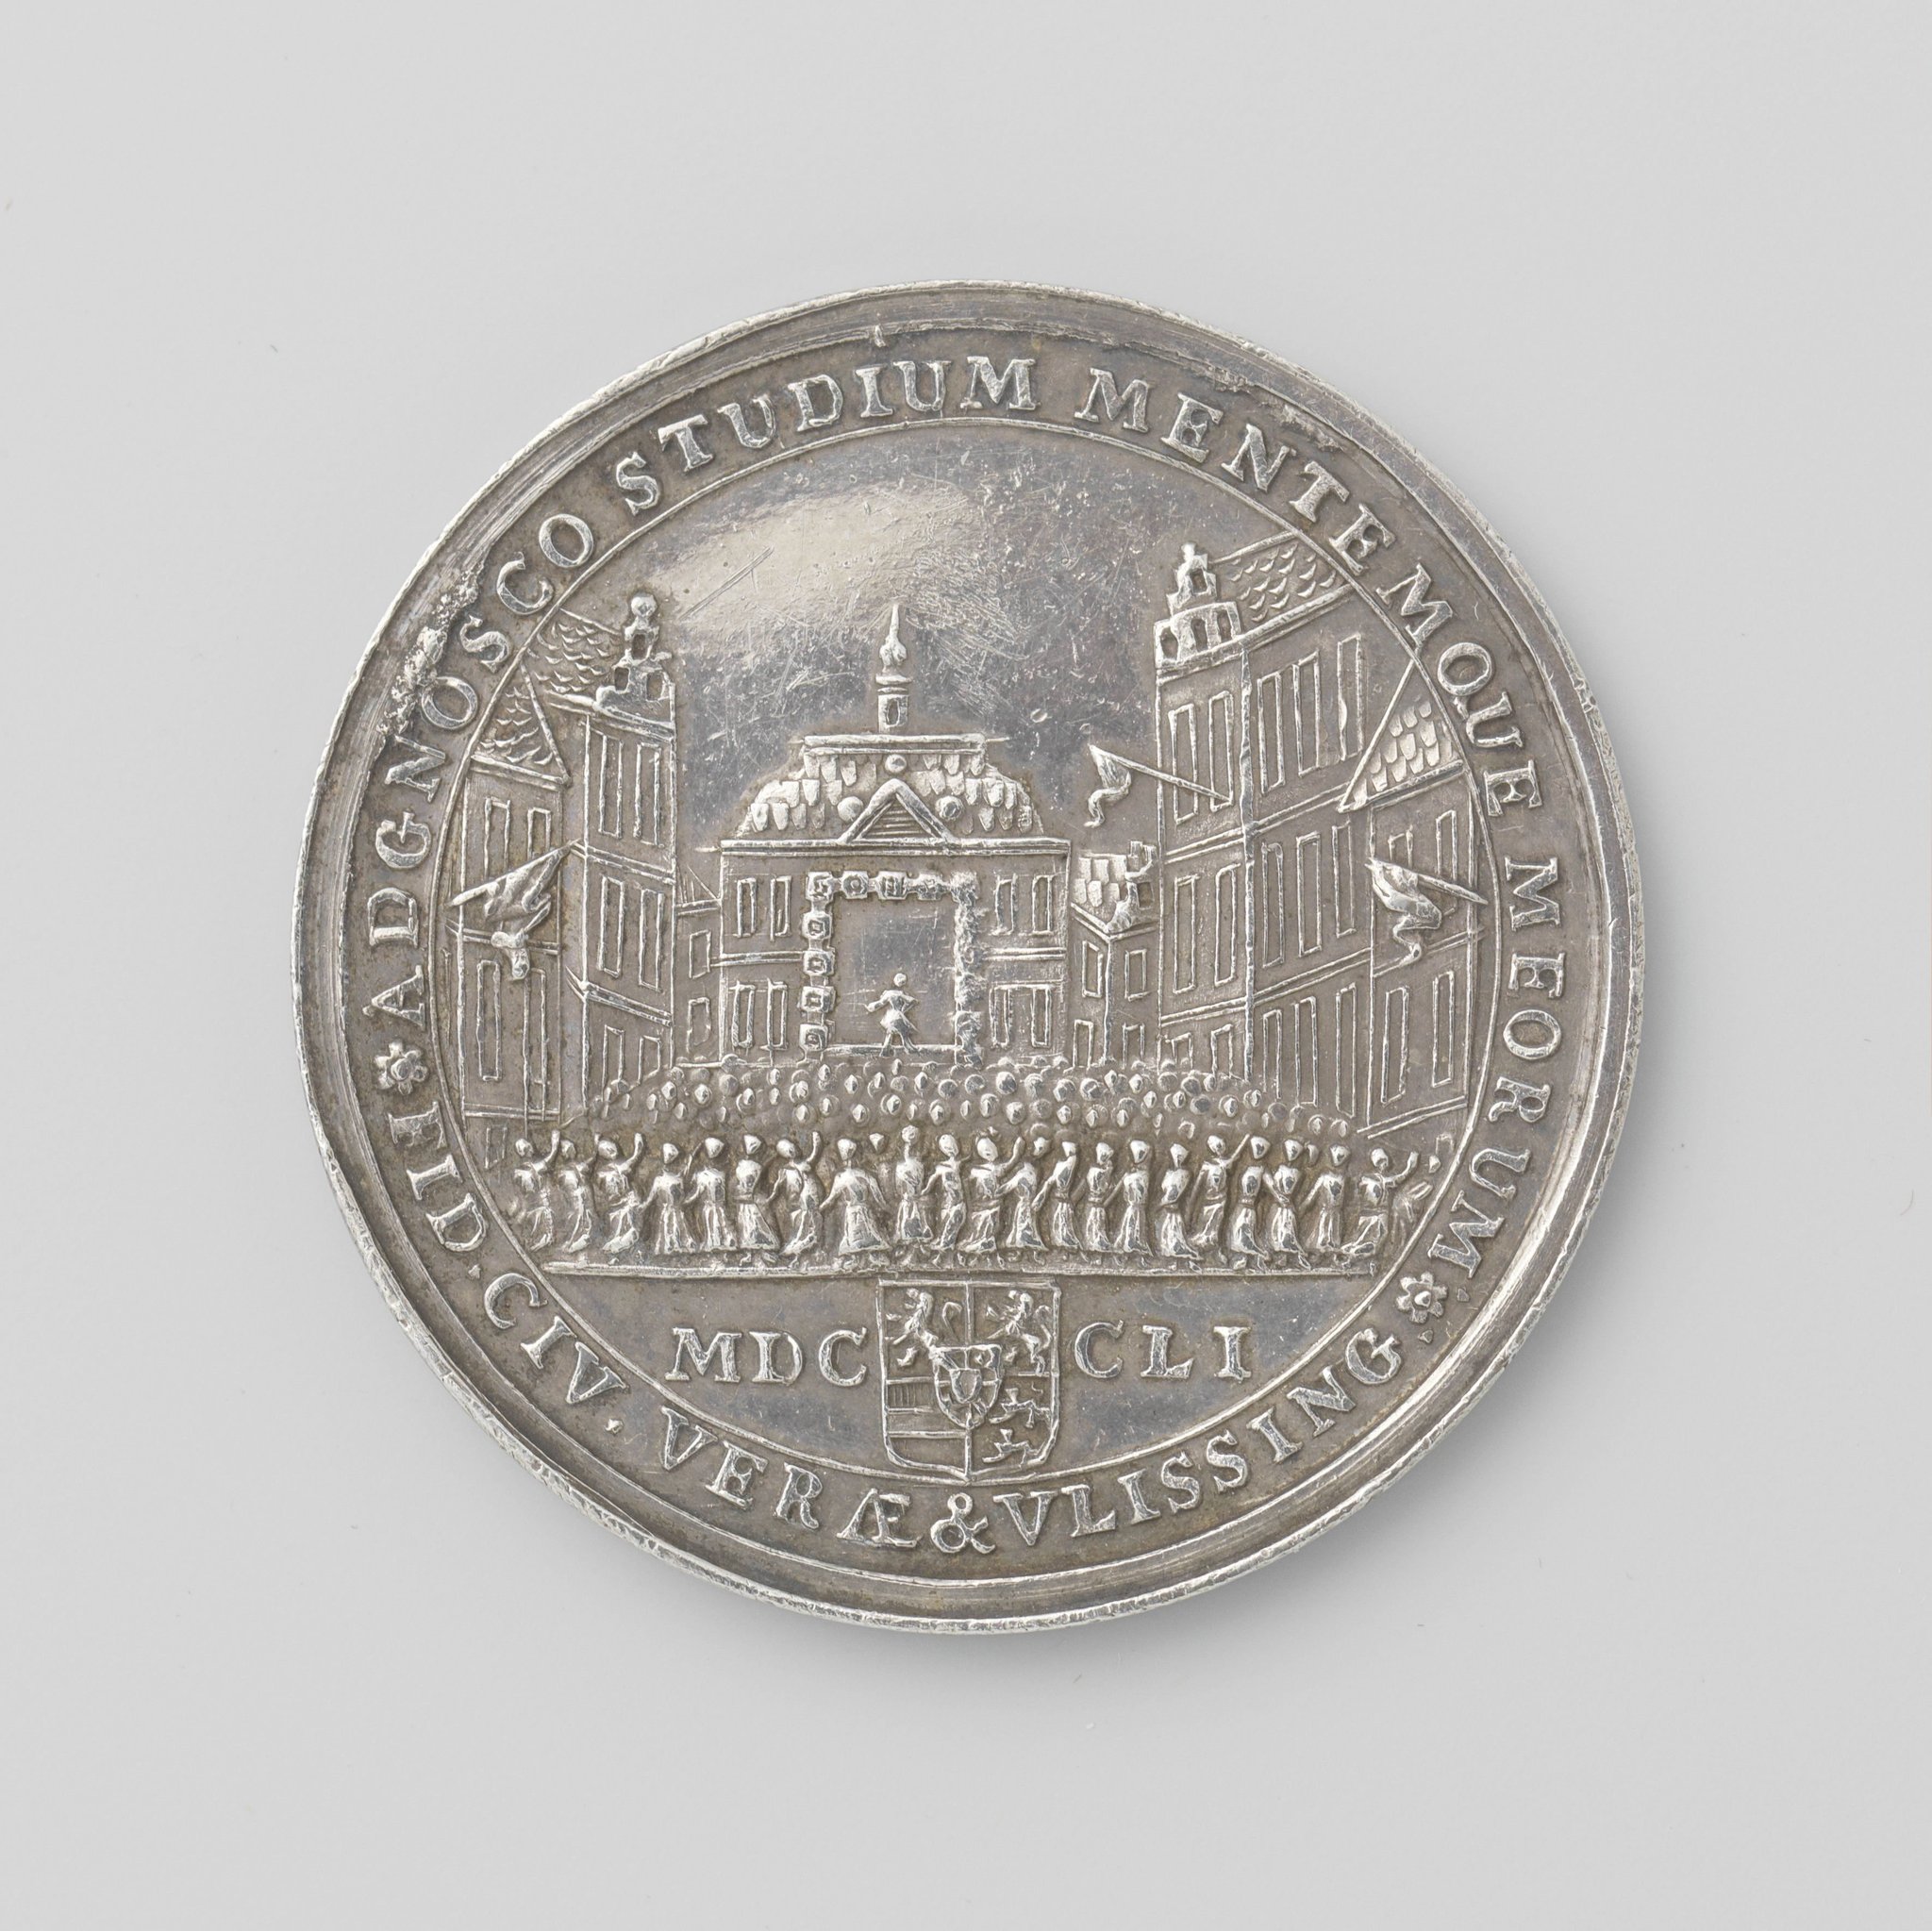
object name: strooipenning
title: Inhuldiging van Willem IV als markies van Vlissingen en Veere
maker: nicolaas van swinderen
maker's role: jeweler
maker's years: 1705-1760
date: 1751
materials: silver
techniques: striking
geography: the hague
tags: willem iv (prins van oranje-nassau), flushing